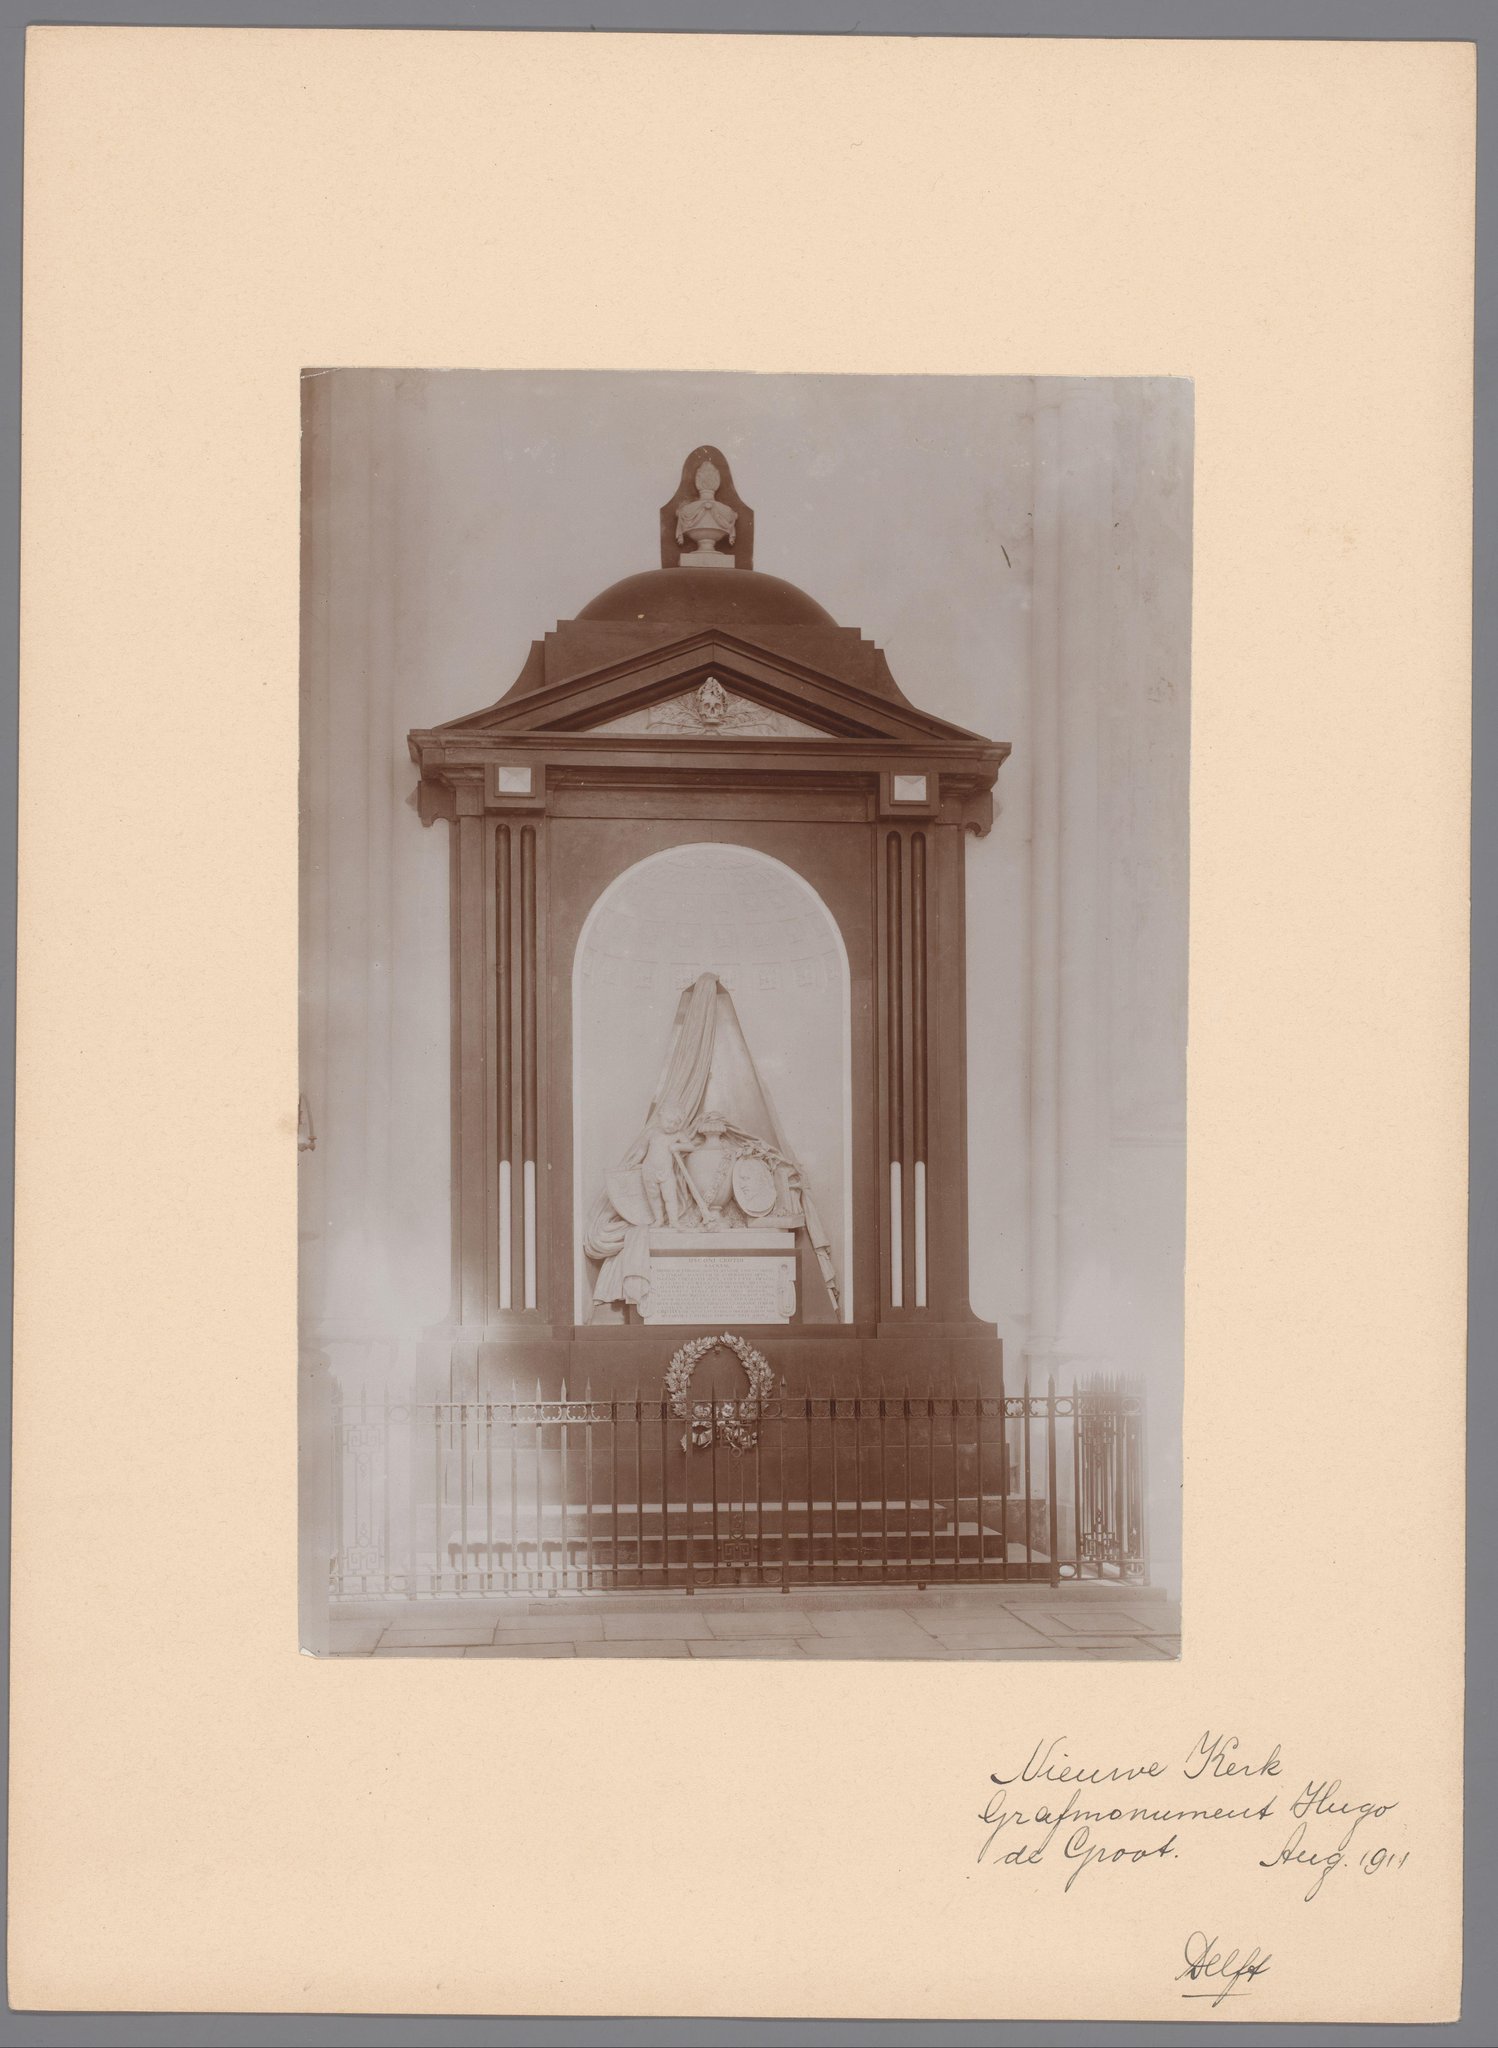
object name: photograph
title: Grafmonument van Hugo de Groot in de Nieuwe Kerk te Delft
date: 1911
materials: cardboard, photographic support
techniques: collodion silver print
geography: nieuwe kerk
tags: hugo de groot, interior of church, grave-building, monumental tomb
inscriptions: annotation: ‘Nieuwe Kerk/ grafmonument Hugo de Groot/ Aug. 1911/ Delft’